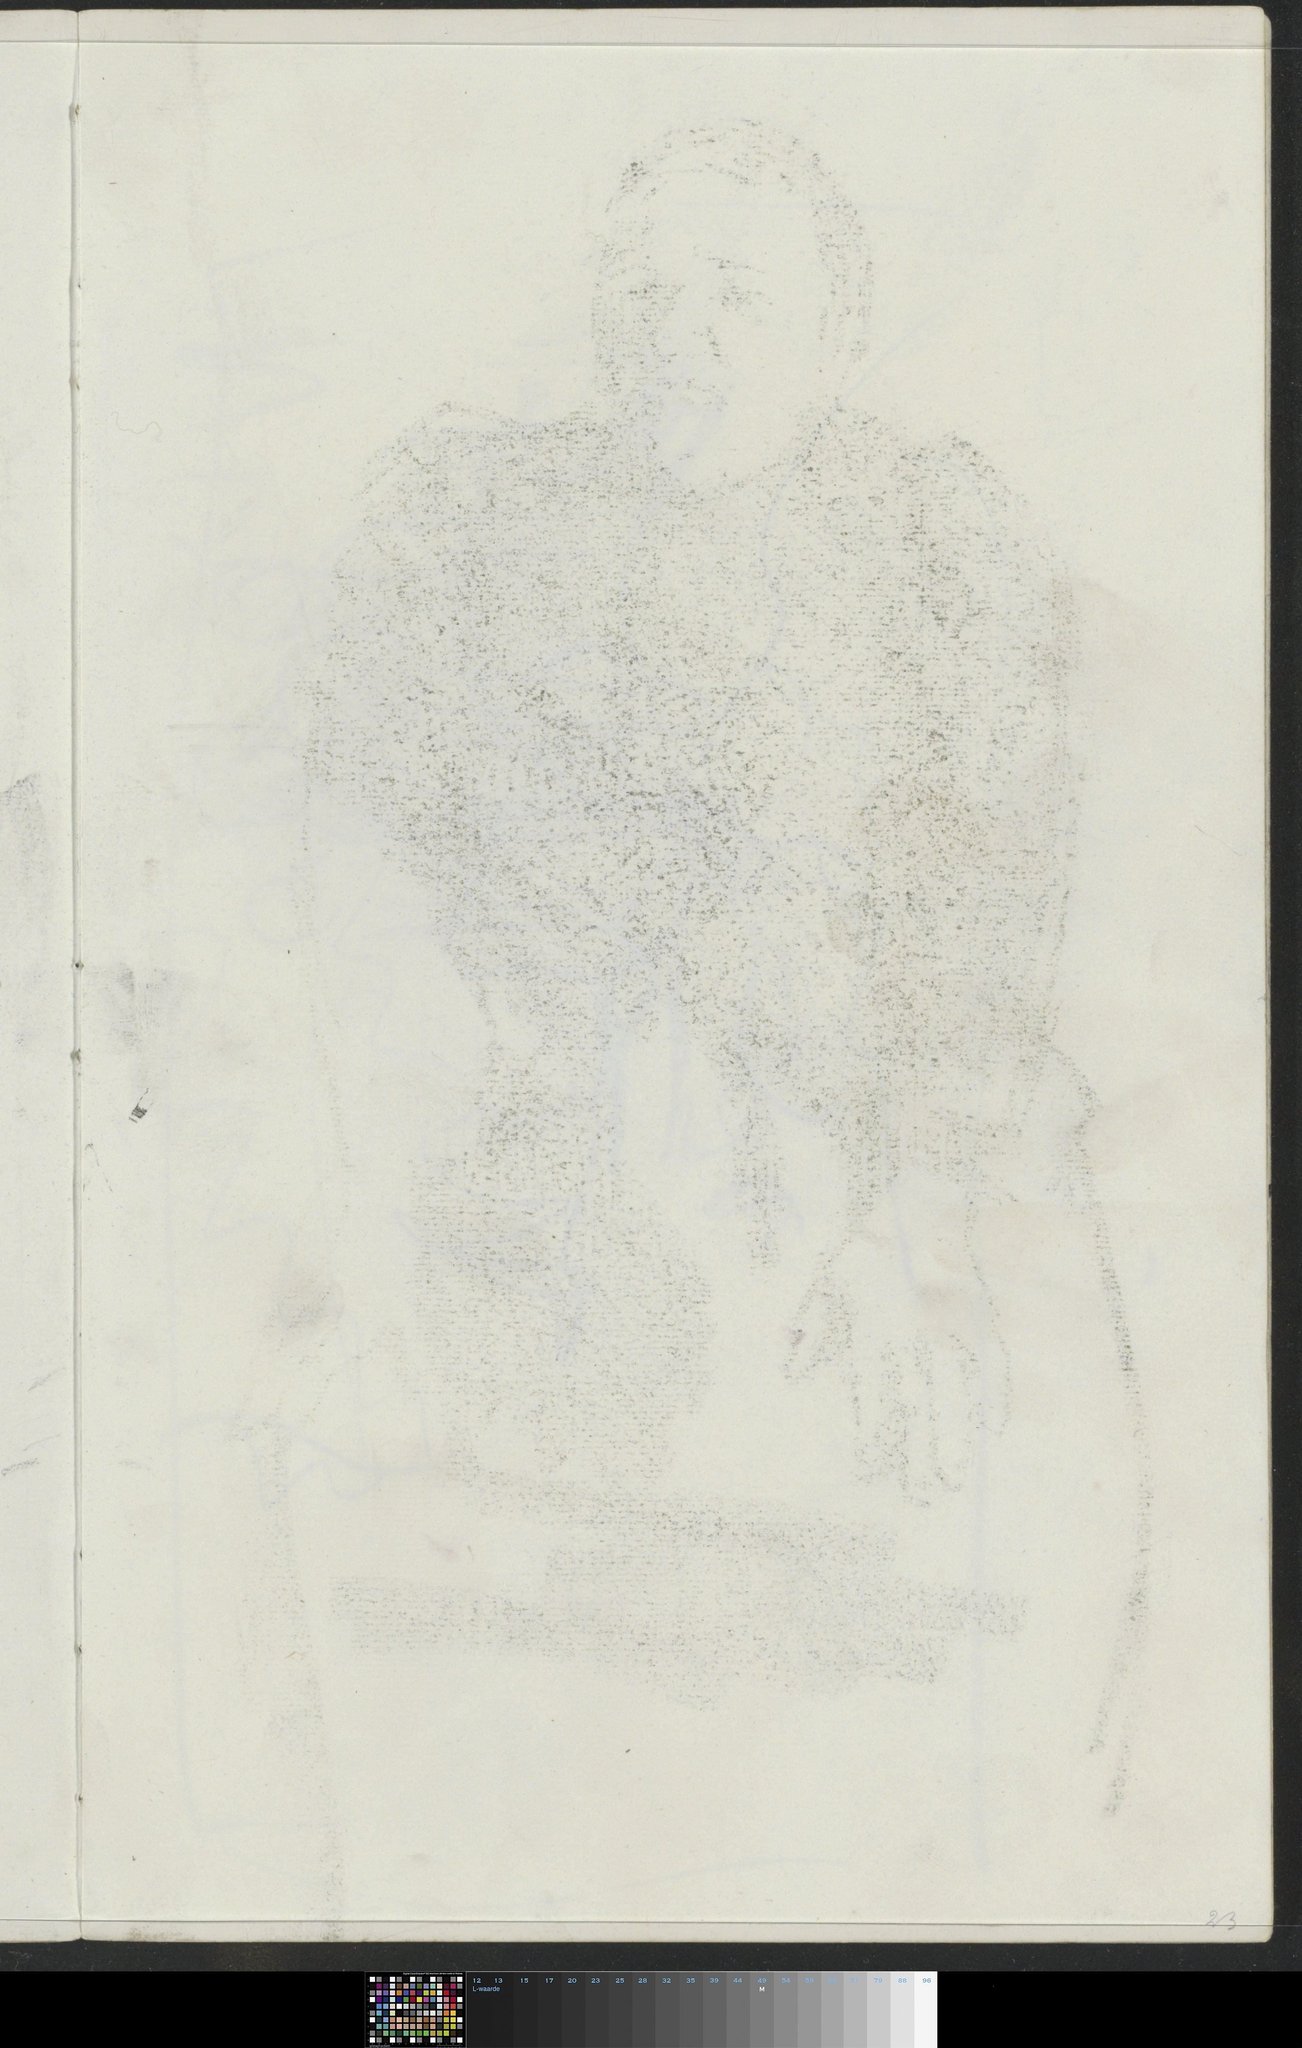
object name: sketchbook leaf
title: Abklatsch van de krijttekening op blad 22 verso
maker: isaac israels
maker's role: draughtsman, painter, print maker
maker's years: 1865-1934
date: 1875-1934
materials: paper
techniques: printmaking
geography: amsterdam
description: Blad 23 recto uit schetsboek XI met 30 bladen.